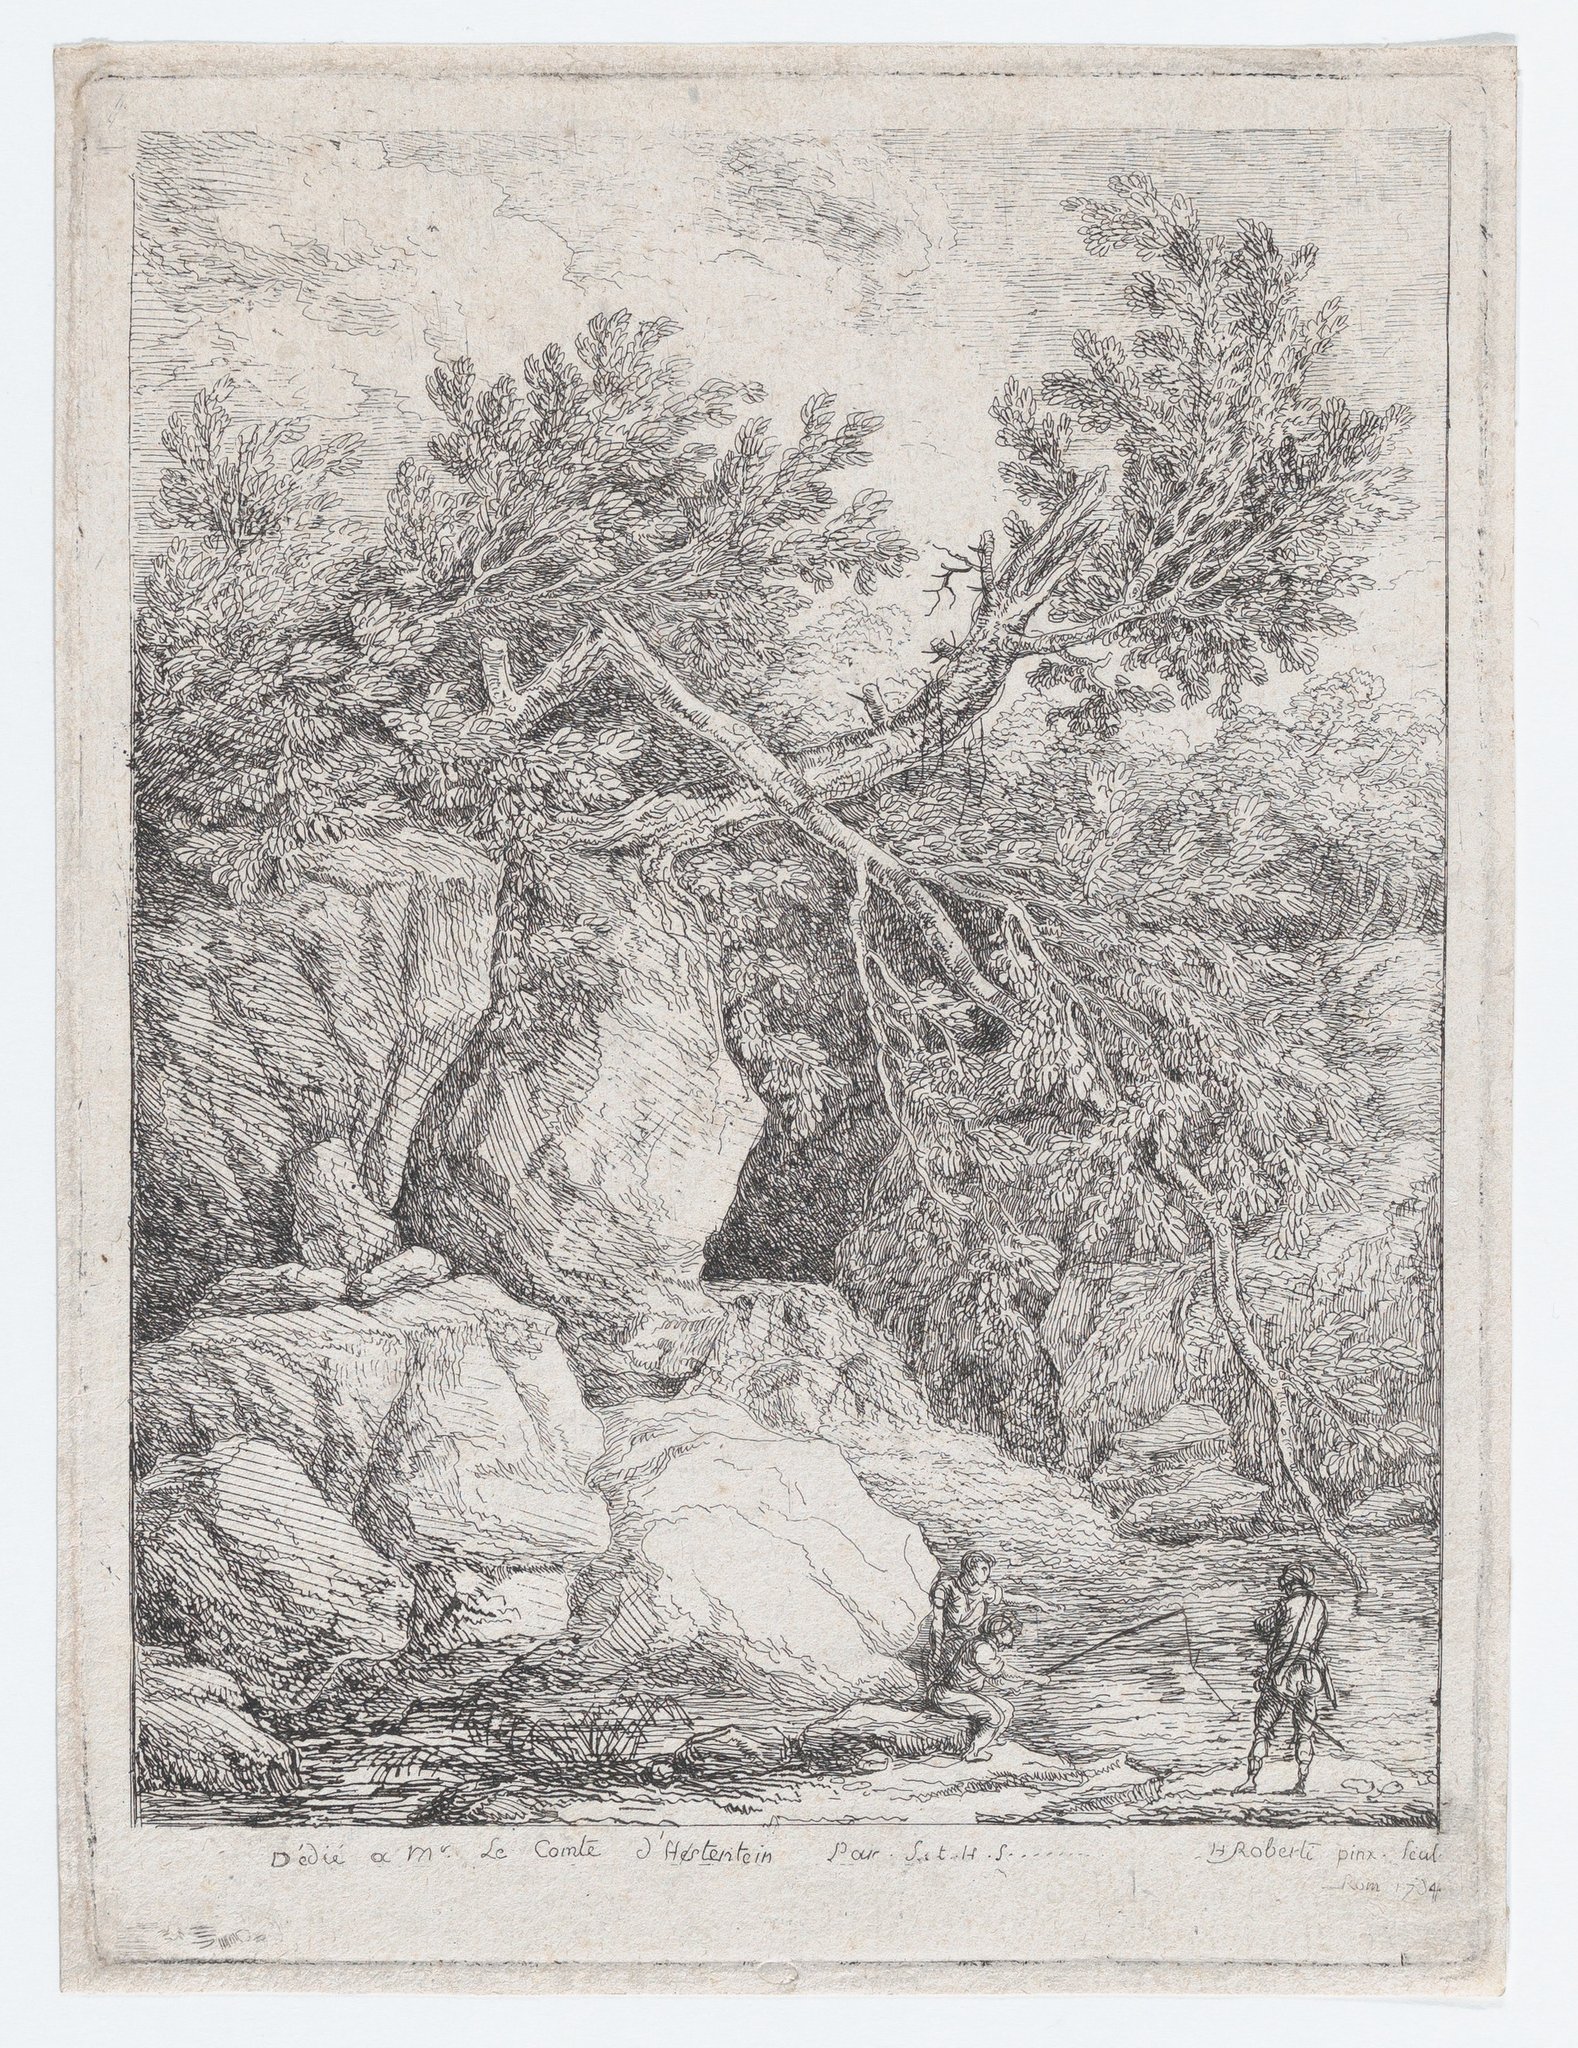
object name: print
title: Landscape with a Fallen Tree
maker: hubert robert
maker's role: artist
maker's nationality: french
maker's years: 1733-1808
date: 1764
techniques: etching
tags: landscapes,trees